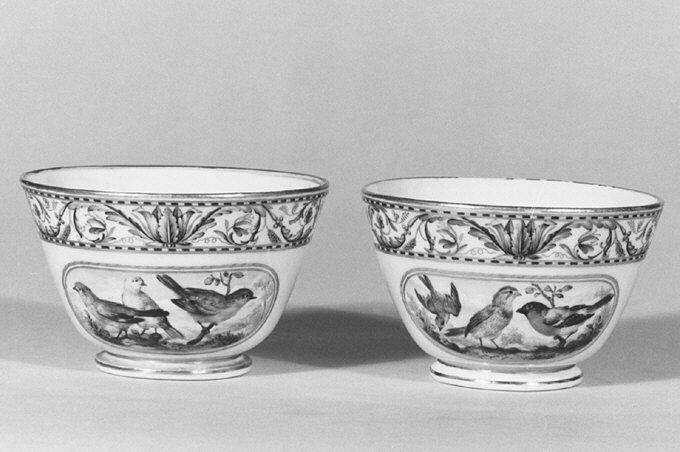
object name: teacup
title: Teacup (part of a service)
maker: meissen manufactory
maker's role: manufactory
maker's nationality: german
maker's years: 1710-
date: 1780-1785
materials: hard paste porcelain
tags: birds,flowers